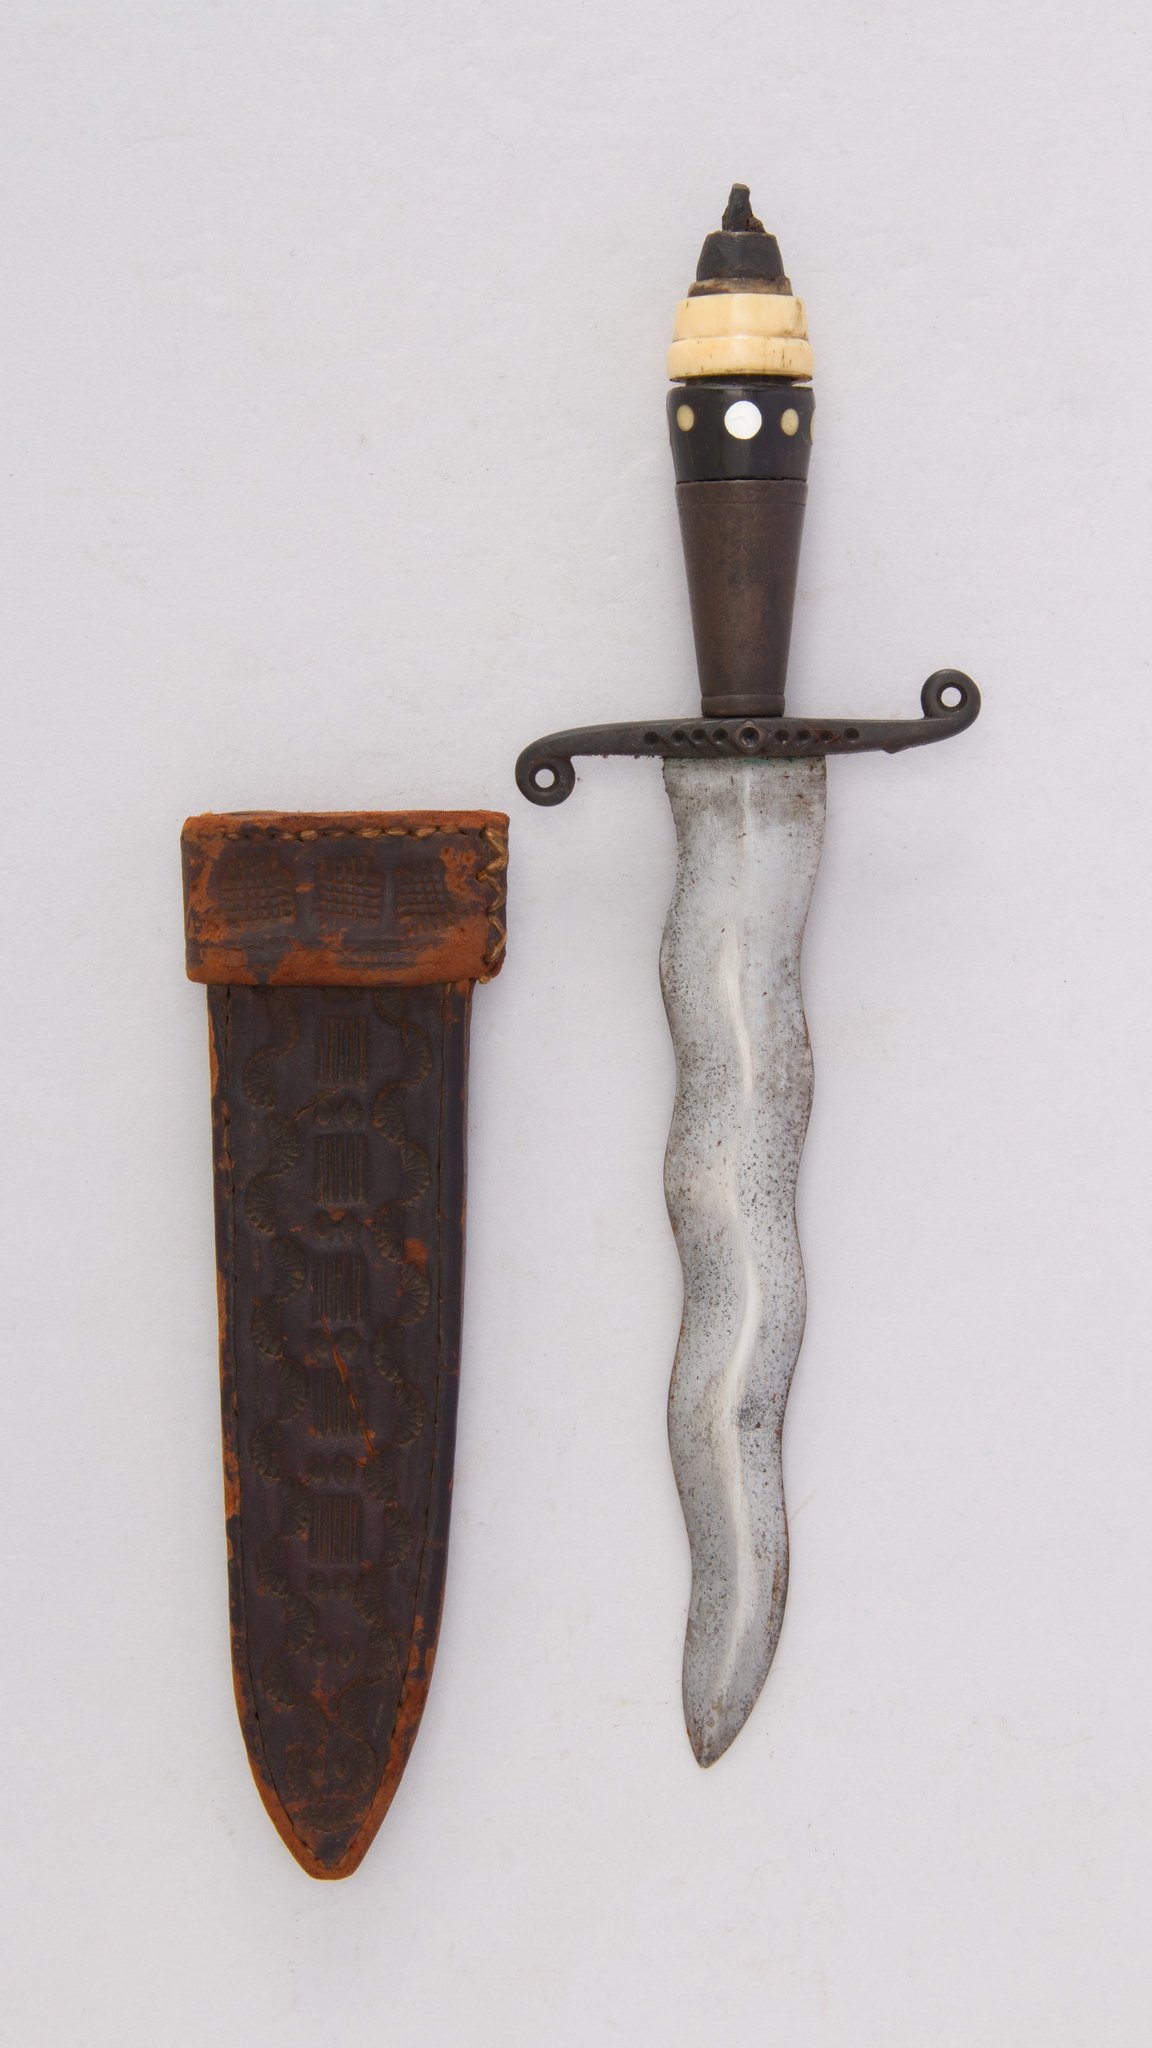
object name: dagger with sheath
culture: philippine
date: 1701-1900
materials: brass, horn, leather, mother of pearl, steel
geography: philippines